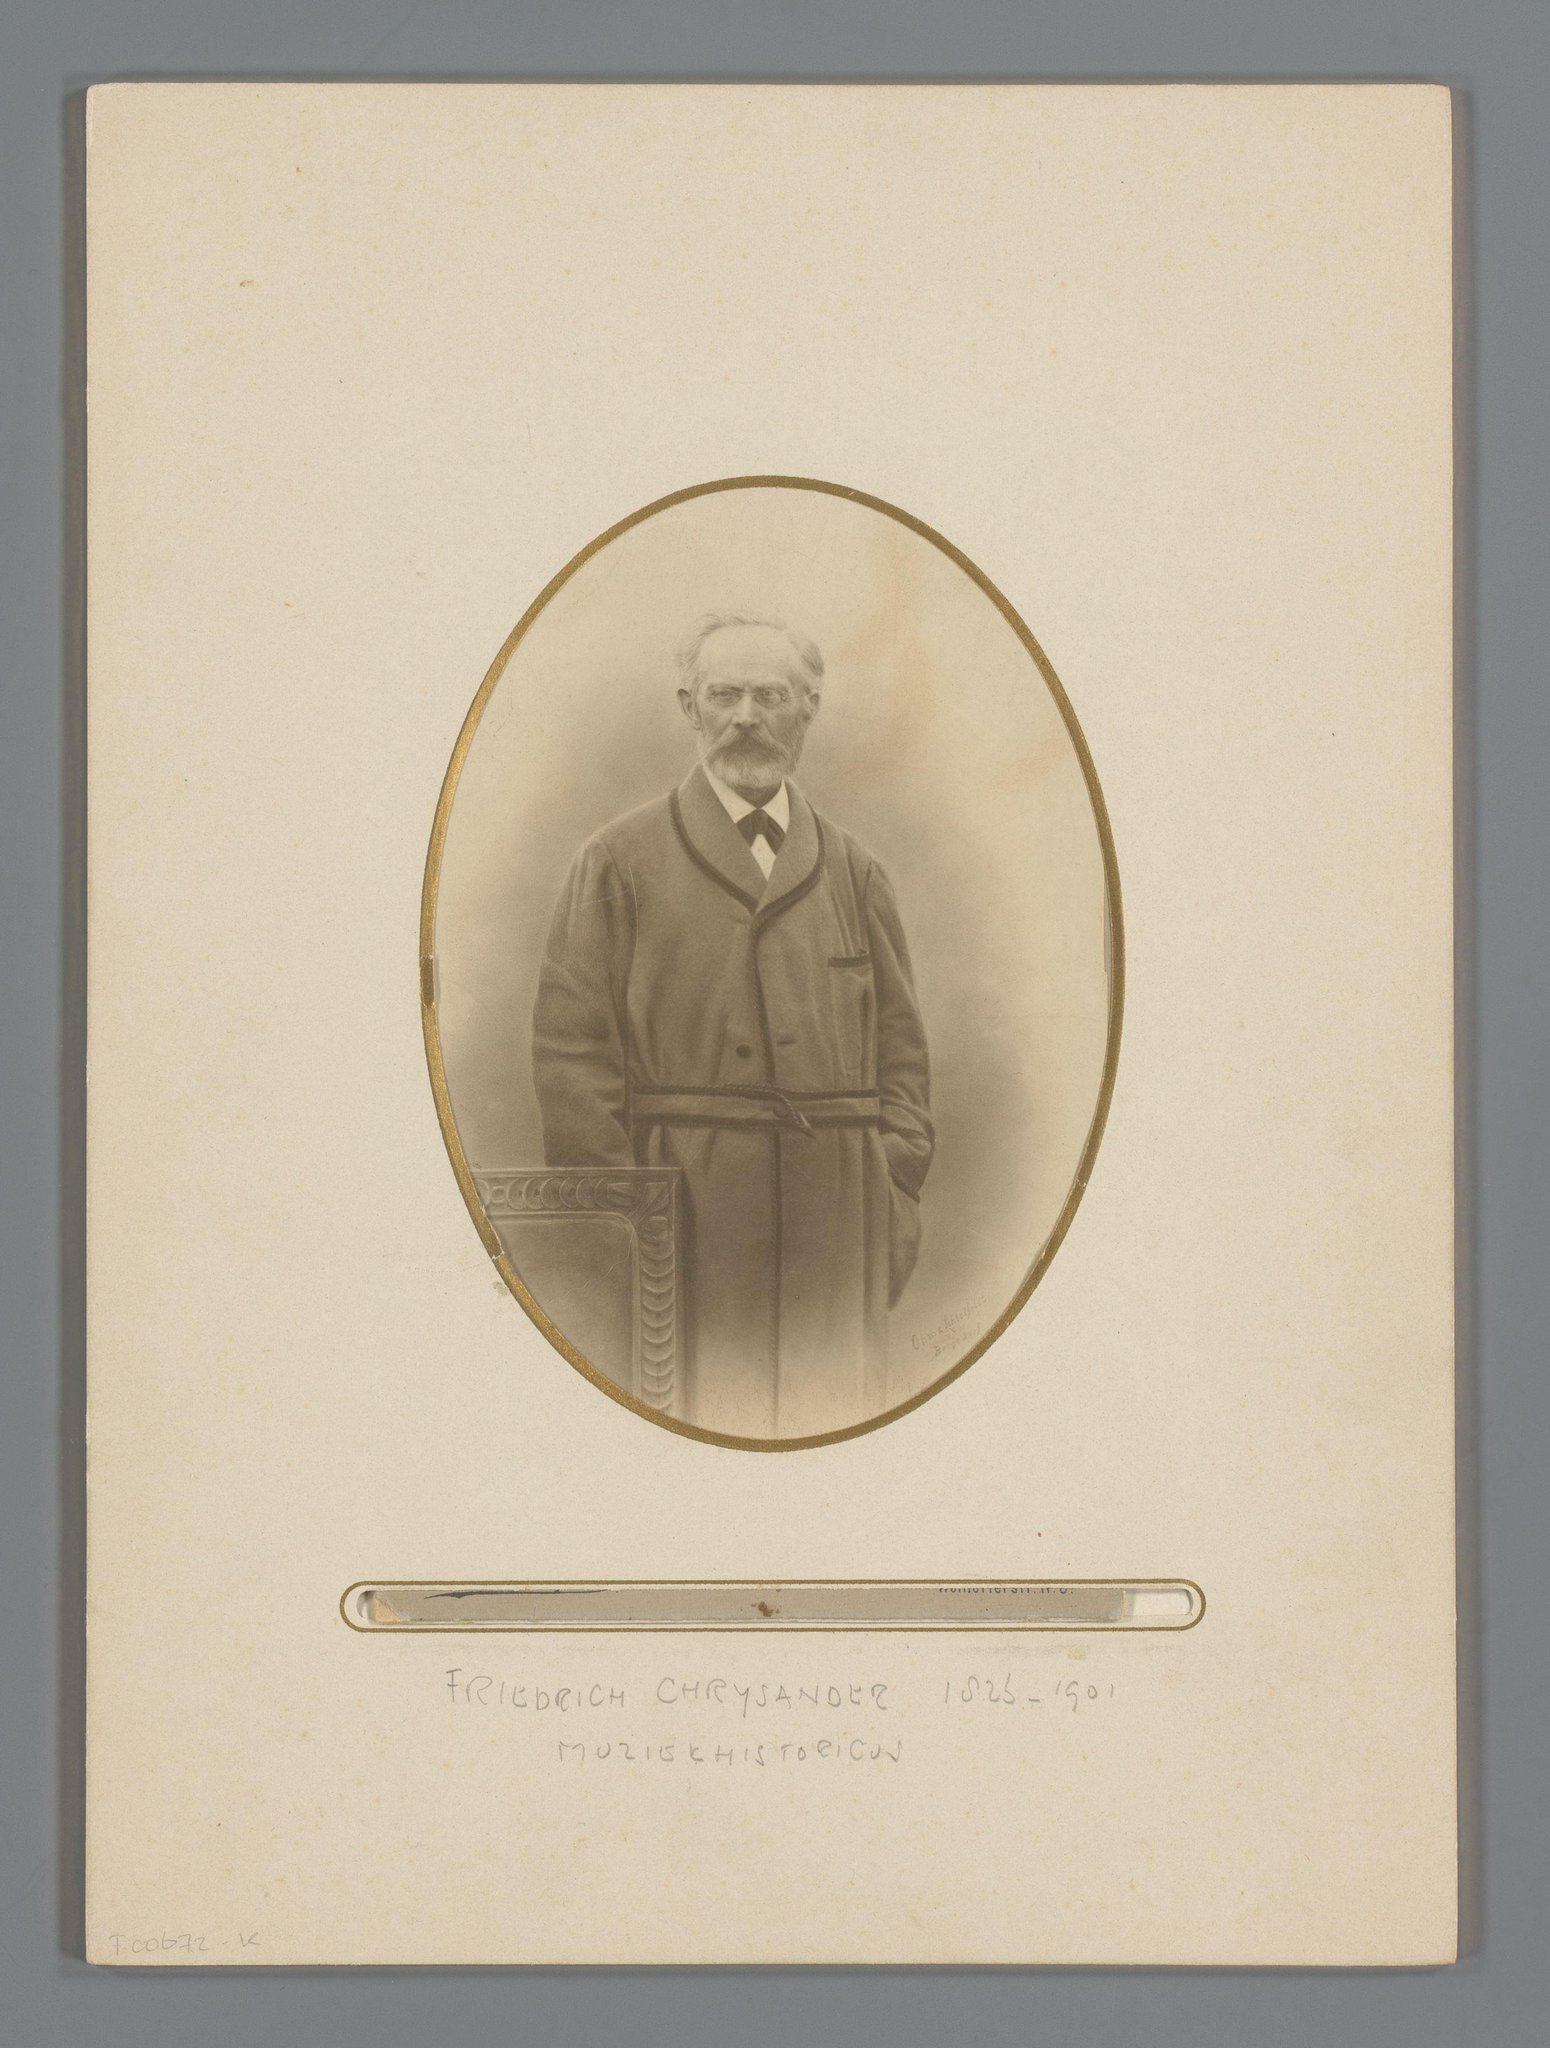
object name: photograph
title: Portret van Friedrich Chrysander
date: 1901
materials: cardboard, photographic support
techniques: gelatin silver print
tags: adult man, historical persons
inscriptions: annotation: ‘Friedrich Chrysander/ aufnahme vom 8 Juni 1901 (75 Geburtstag) † Sept 1901’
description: Deze foto maakt deel uit van een omslag met 22 foto's.